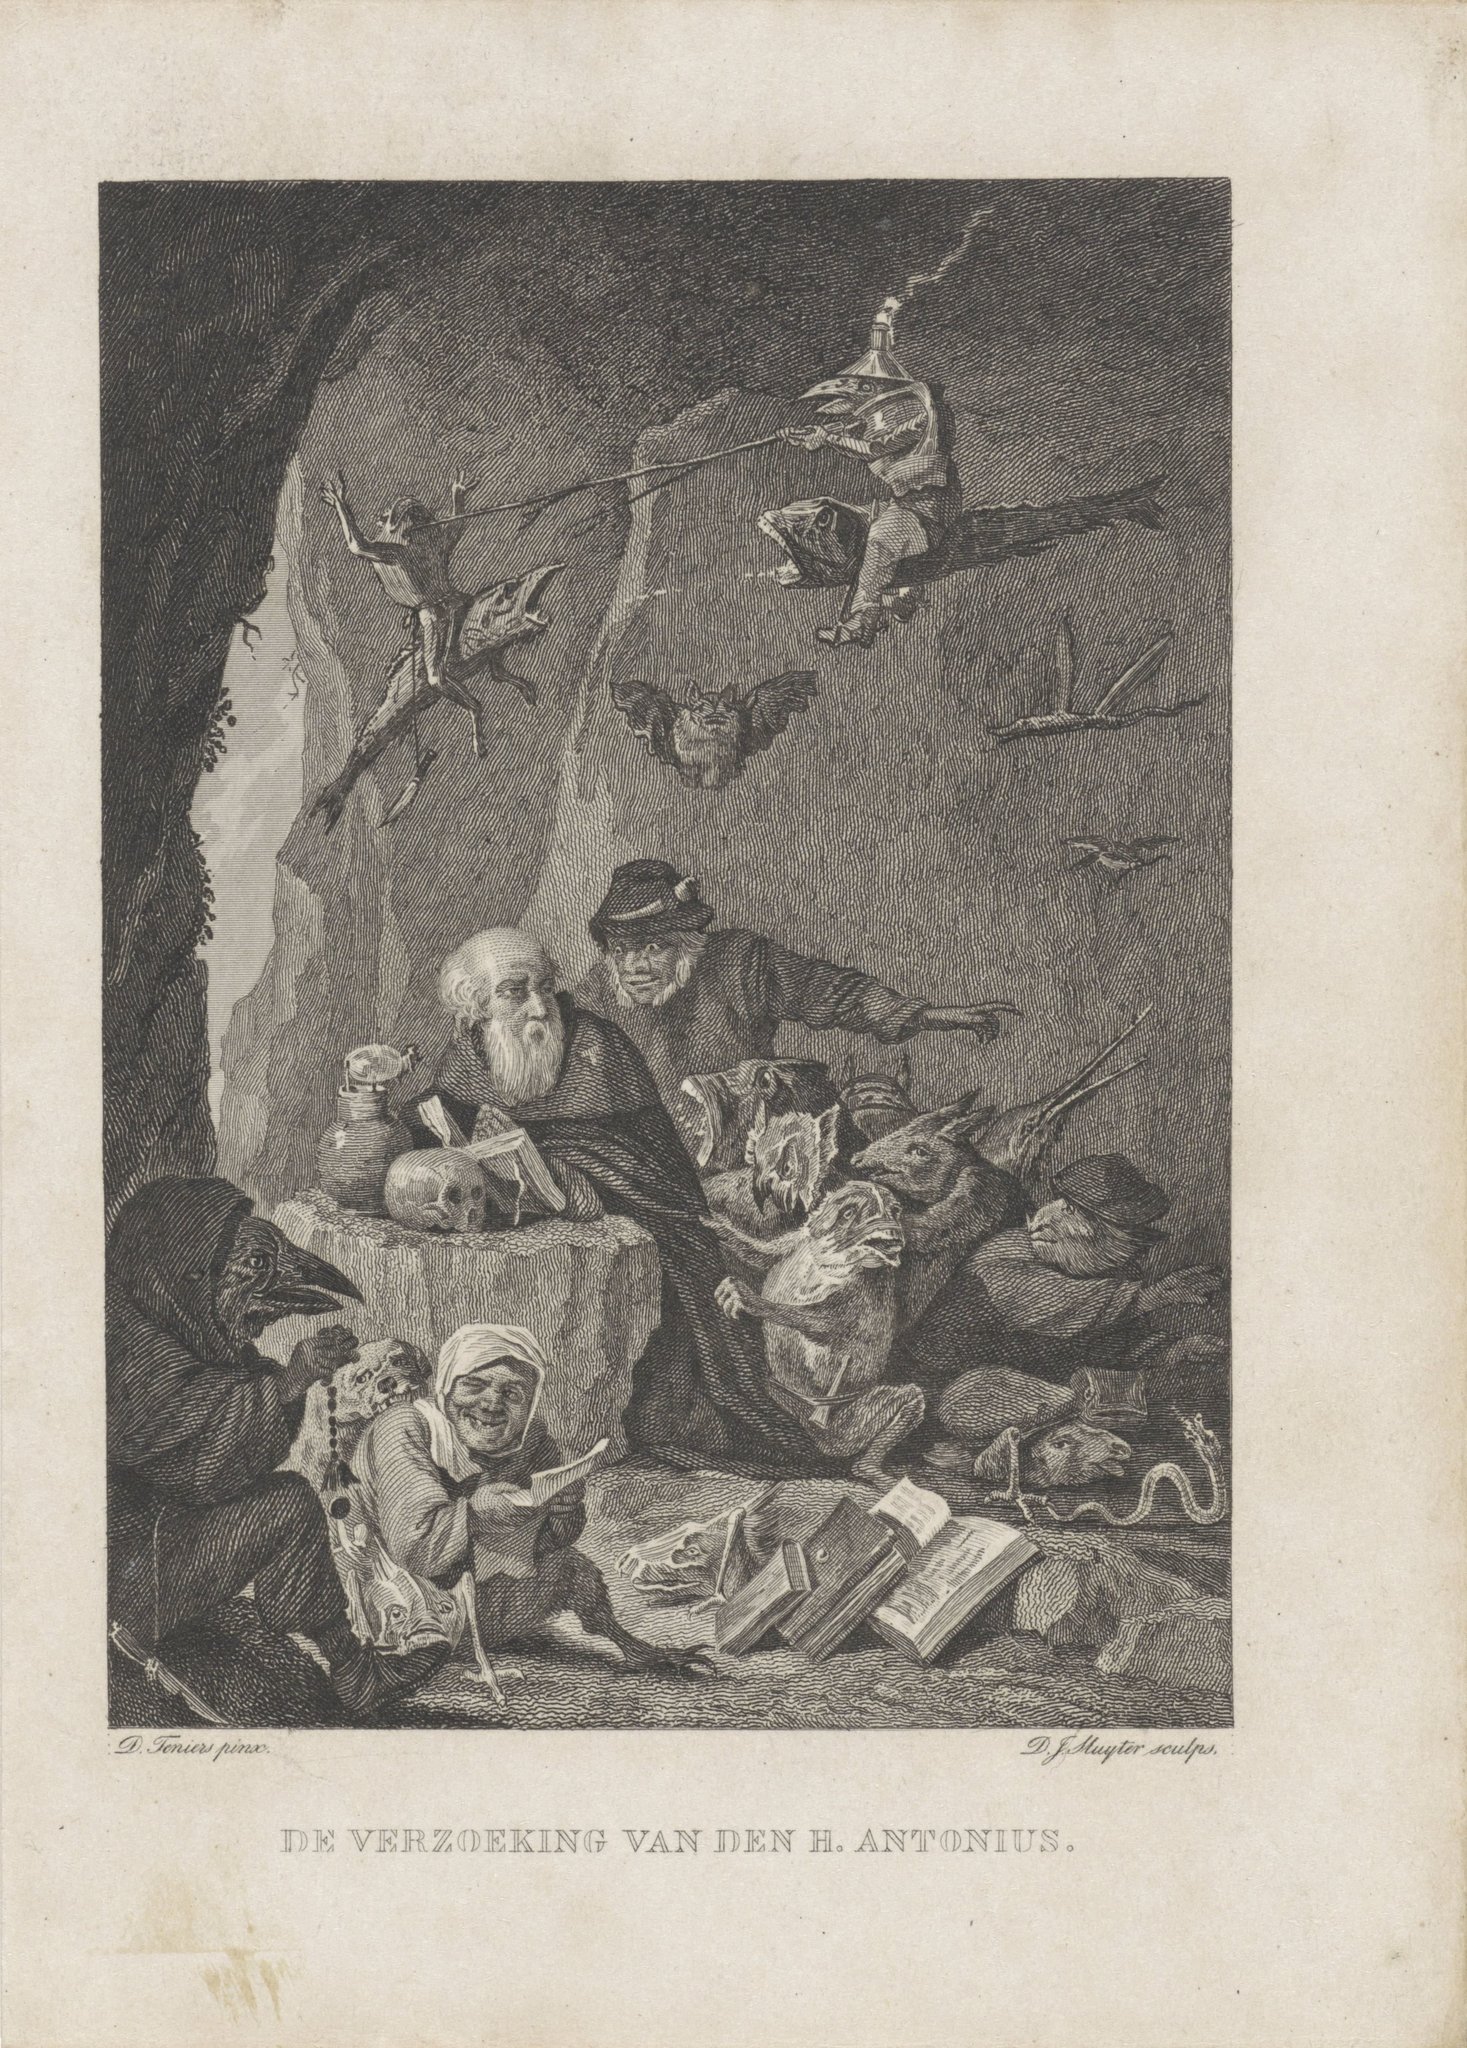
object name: print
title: De verzoeking van den H. Antonius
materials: paper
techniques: engraving, etching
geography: amsterdam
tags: devil(s) and demons, book - mm - book open, book, st. antony abbot tormented by devils, attacking him on the ground or carrying him aloft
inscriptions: collector's mark: Lugt 2228, inscription: ‘Uit Tesselschade v. 1840’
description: De H. Antonius zit geknield te bidden in een grot. Op een rotsblok voor hem liggen een boek en een schedel. Om hem heen vliegen, lopen en zitten demonen in de vorm van wonderlijk gevormde dieren of mensen met dierenledematen. Op de grond liggen boeken.